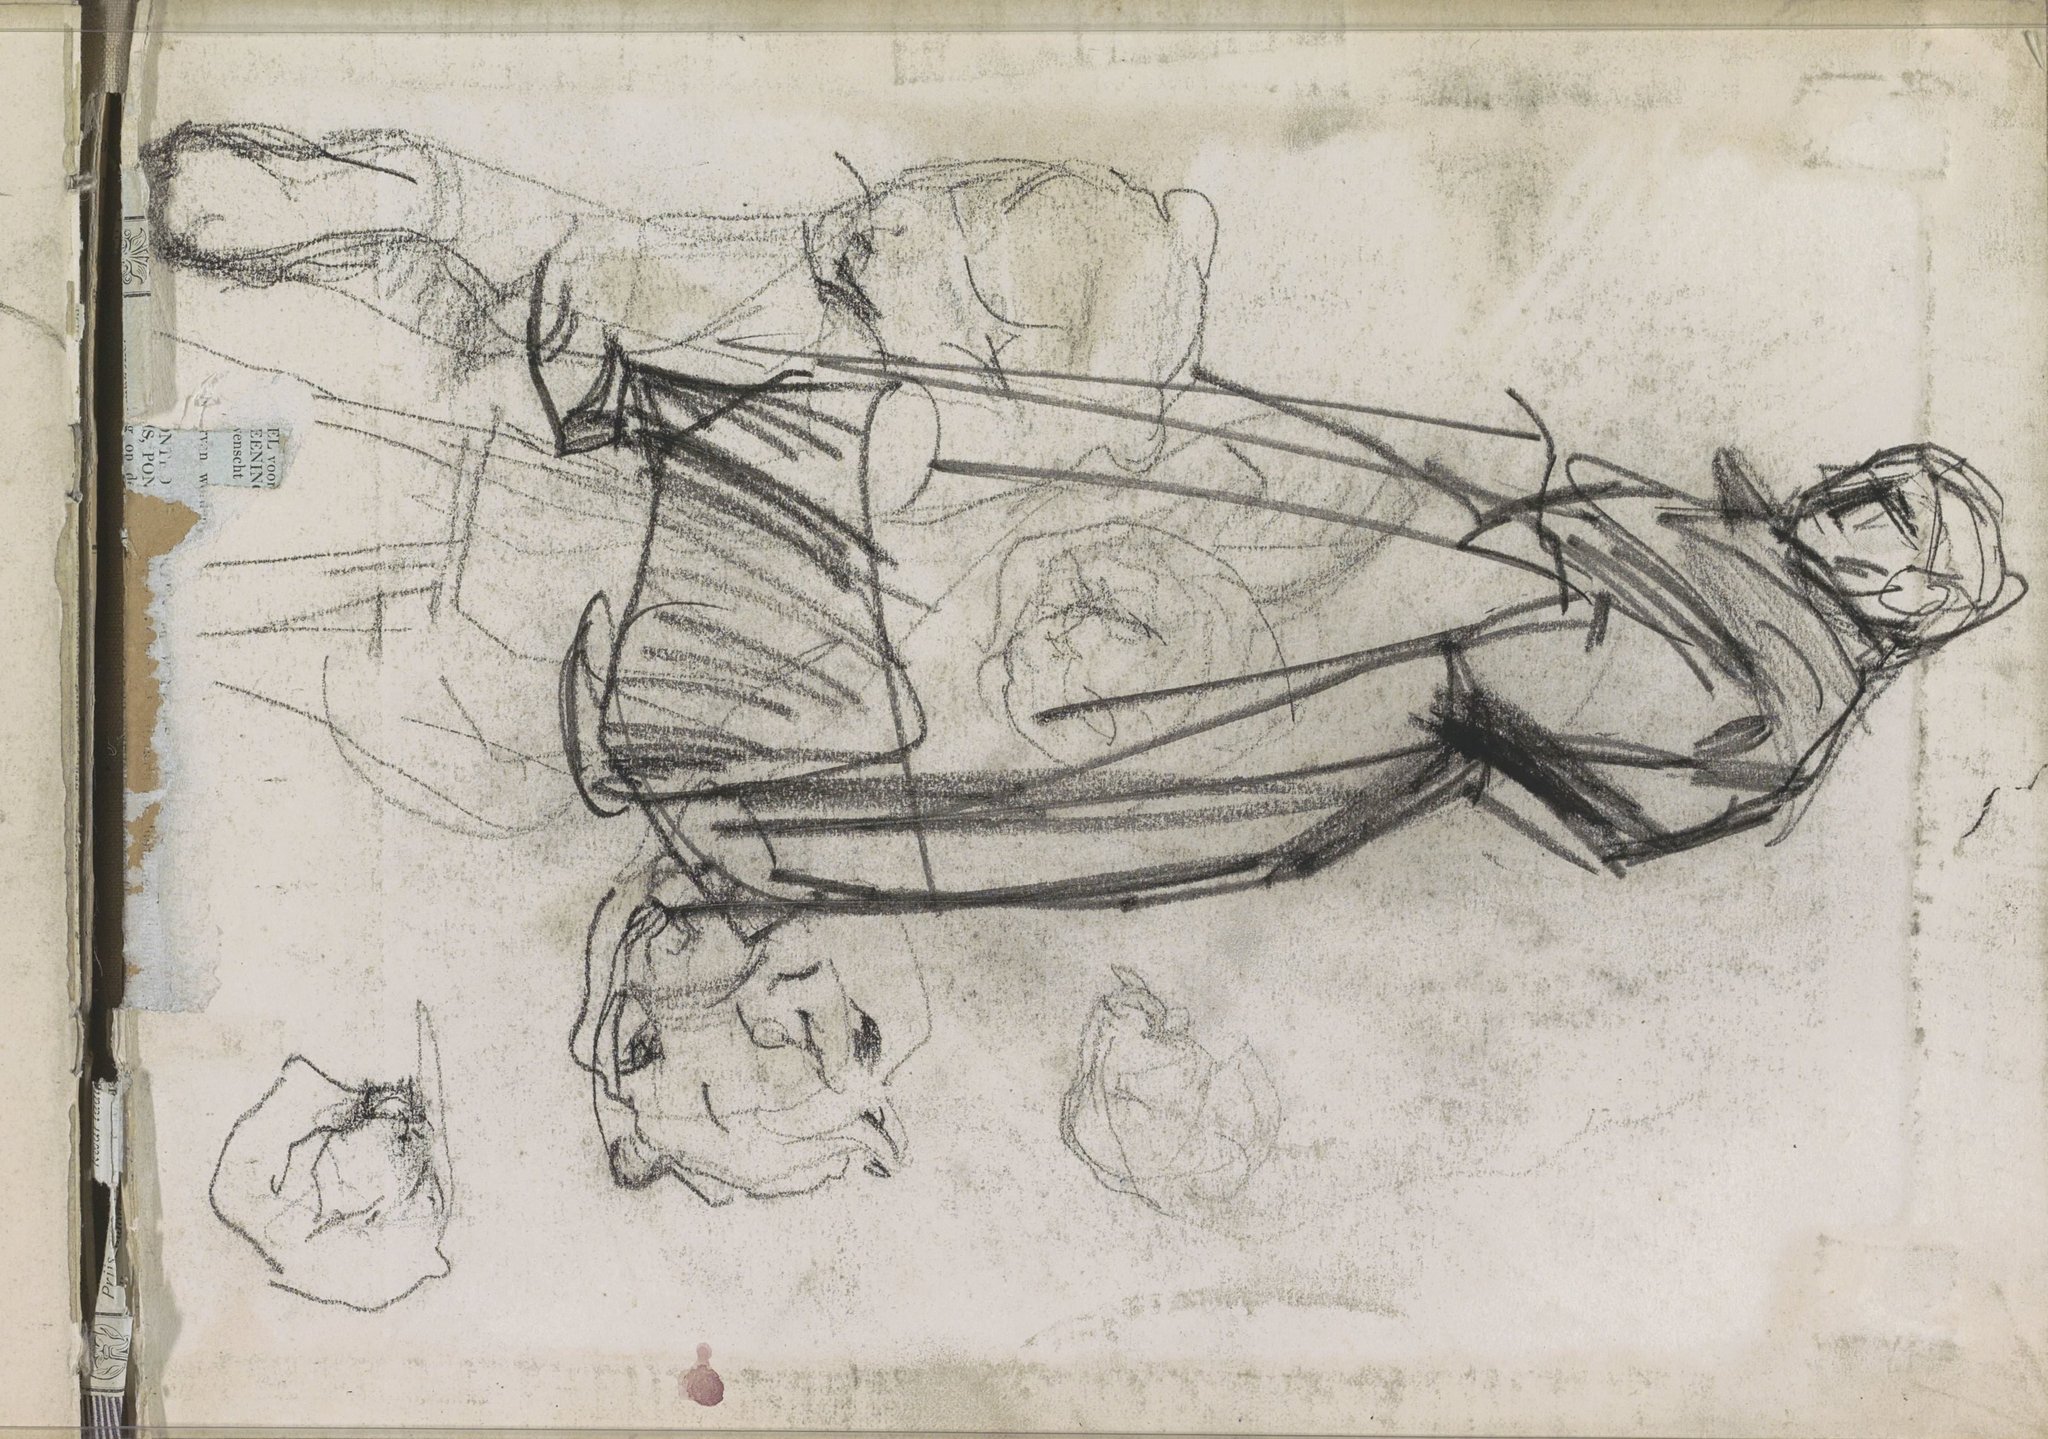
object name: sketchbook leaf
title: Studieblad met een staande vrouw en katachtigen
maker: isaac israels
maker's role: draughtsman, painter, print maker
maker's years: 1865-1934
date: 1892-1900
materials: chalk, paper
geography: the hague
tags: standing figure - aa - female human figure (+ sideview, profile), beasts of prey, predatory animals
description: Mogelijk leeuwinnen. Schutblad B, achterste schutblad, uit schetsboek VIII met 12 bladen.